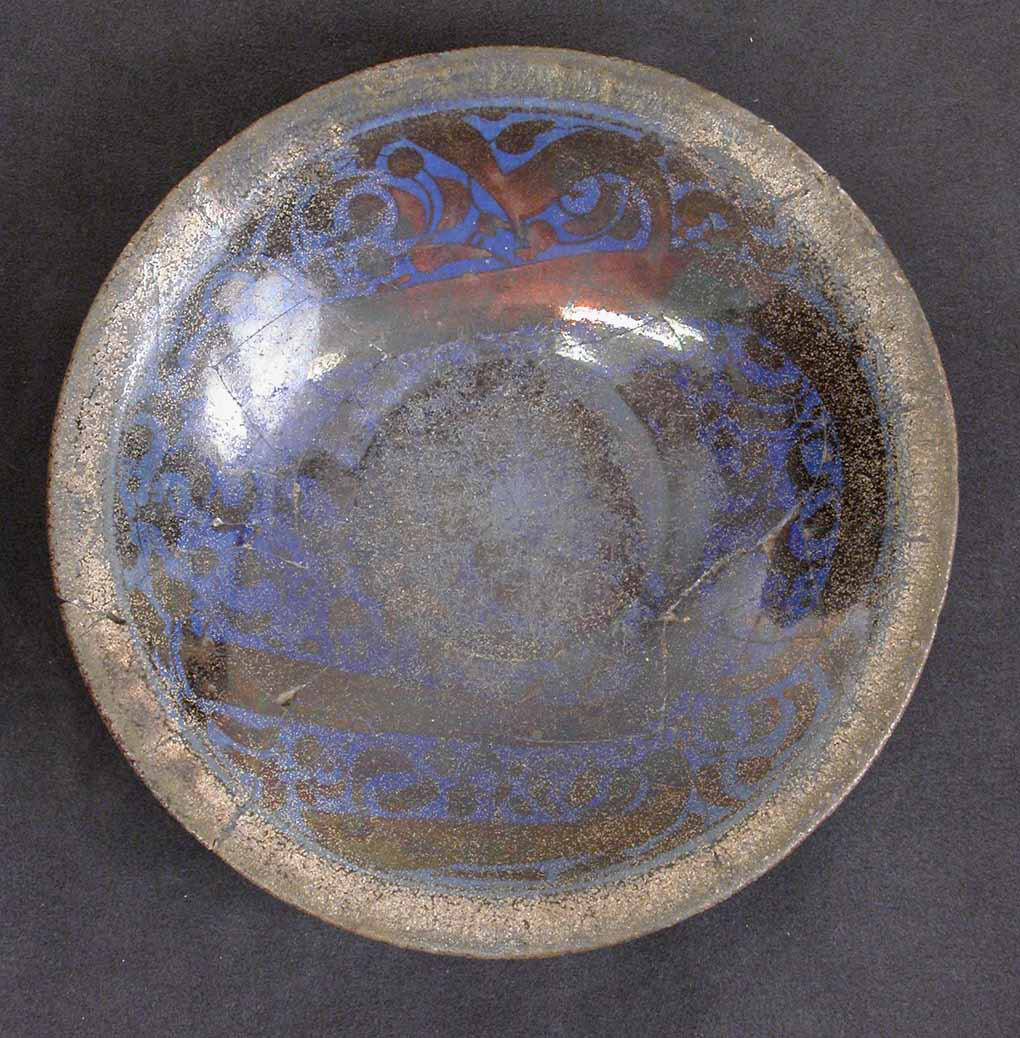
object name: bowl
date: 1134-1166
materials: stonepaste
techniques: luster painting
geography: syria